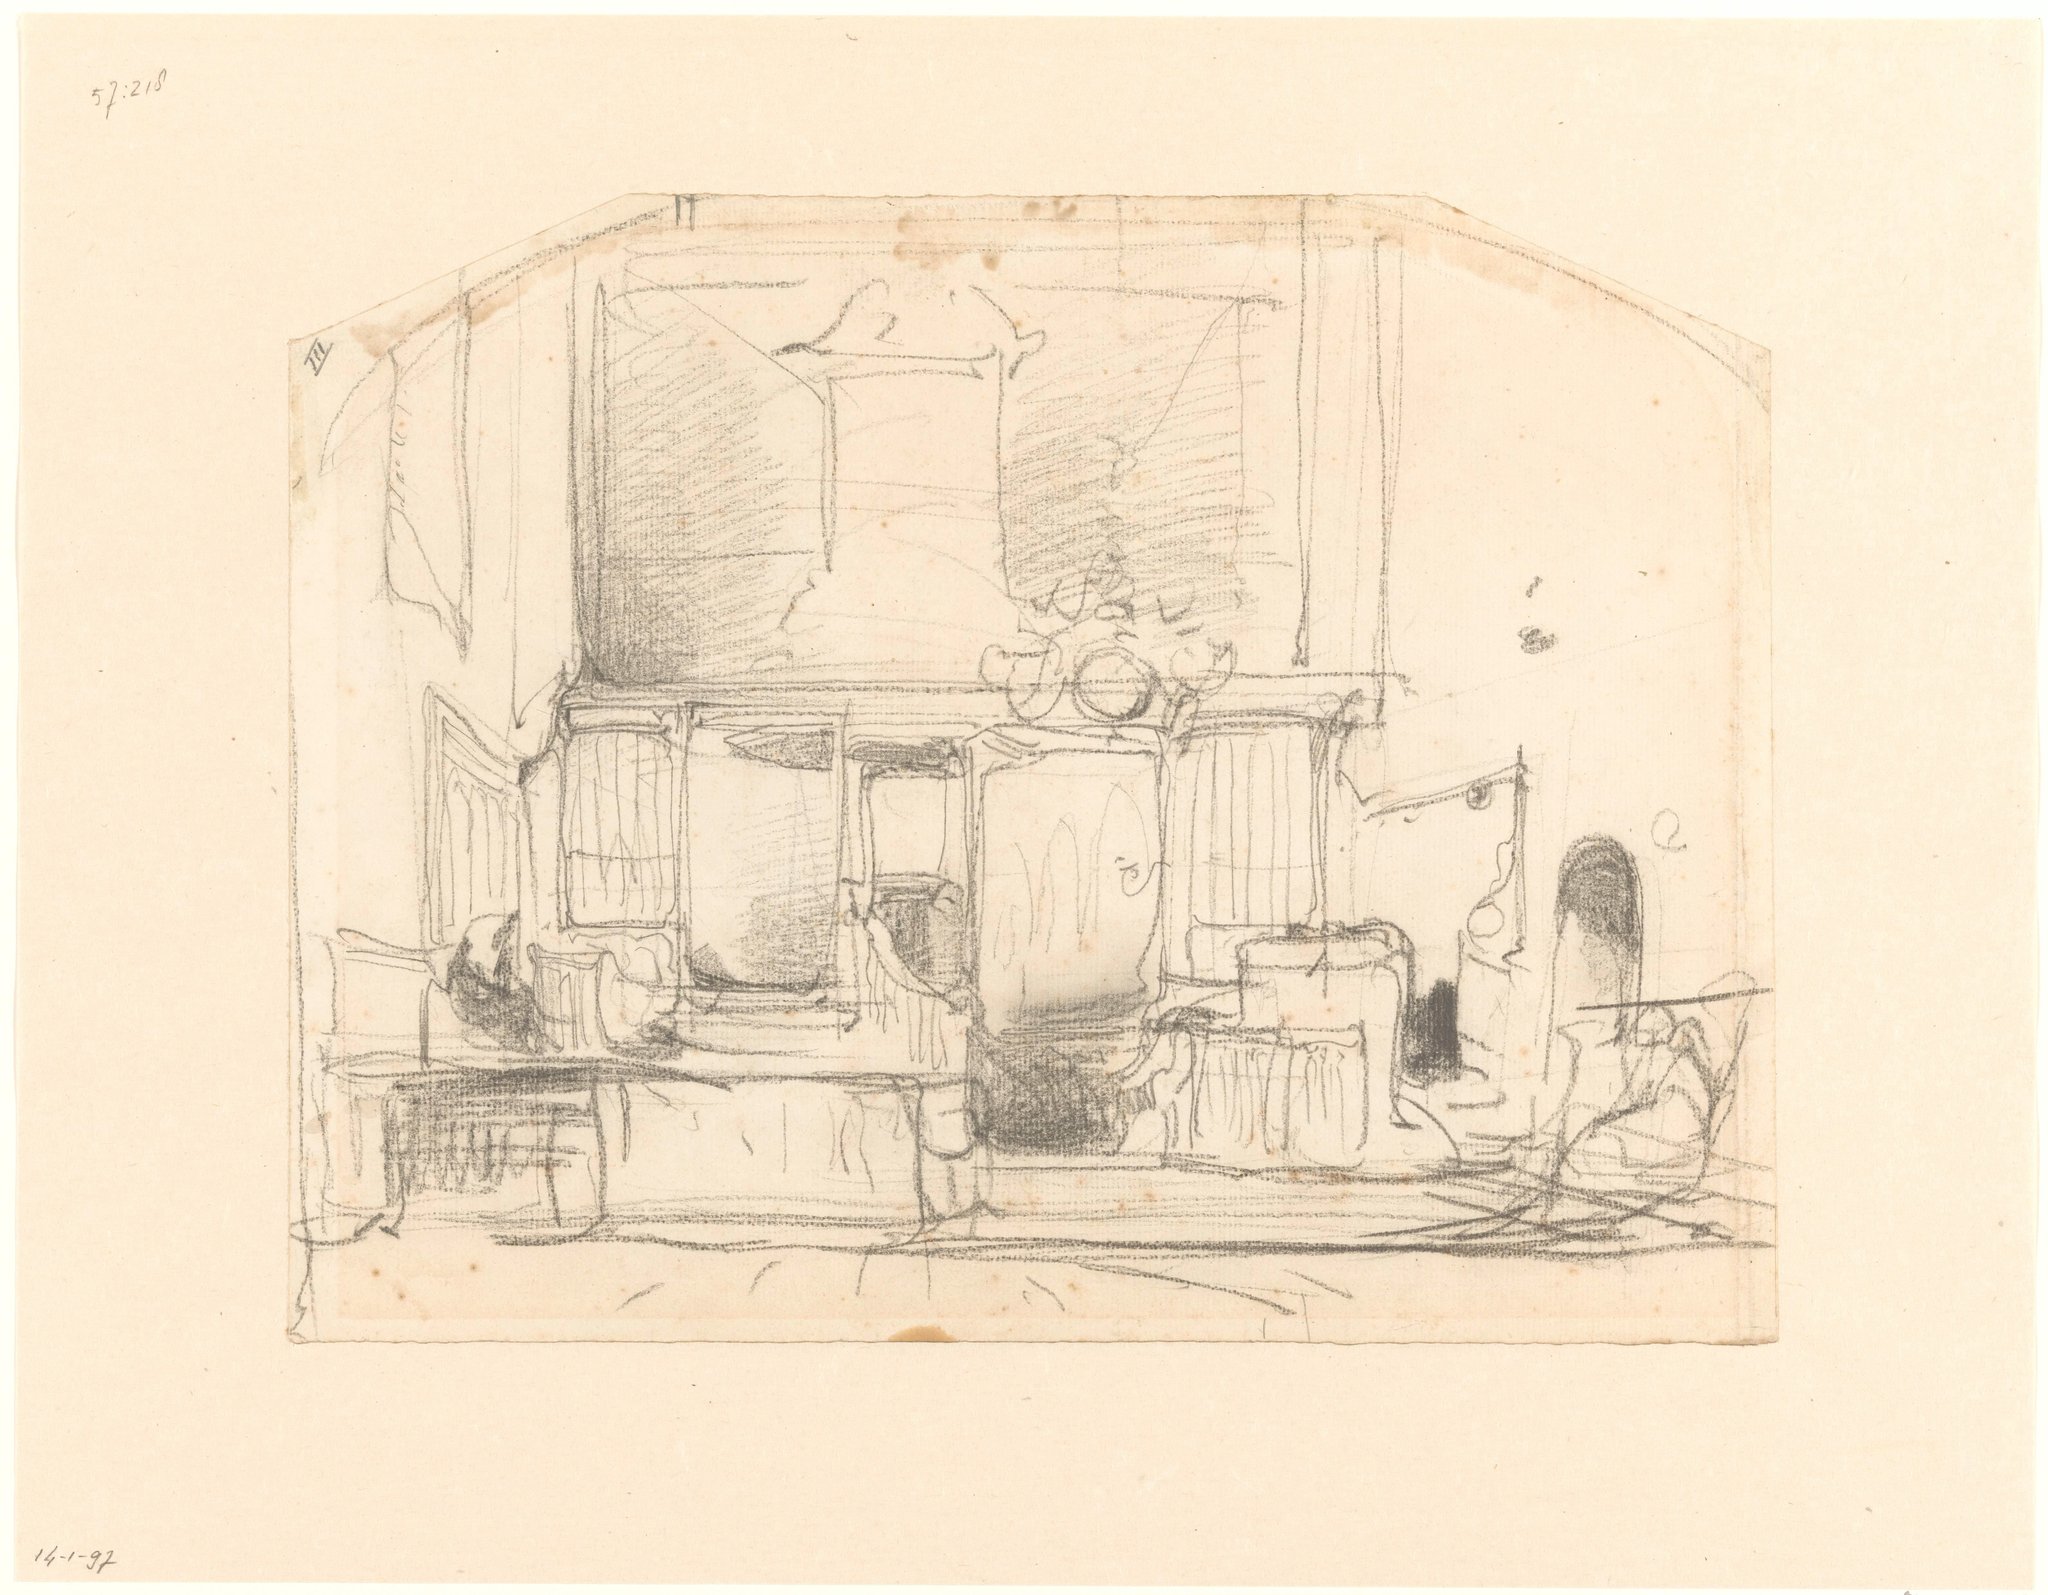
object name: drawing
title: Interieur van de Geertekerk te Utrecht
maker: johannes bosboom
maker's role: draughtsman, painter, print maker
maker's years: 1817-1891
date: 1827-1891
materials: chalk, paper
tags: interior of church, utrecht